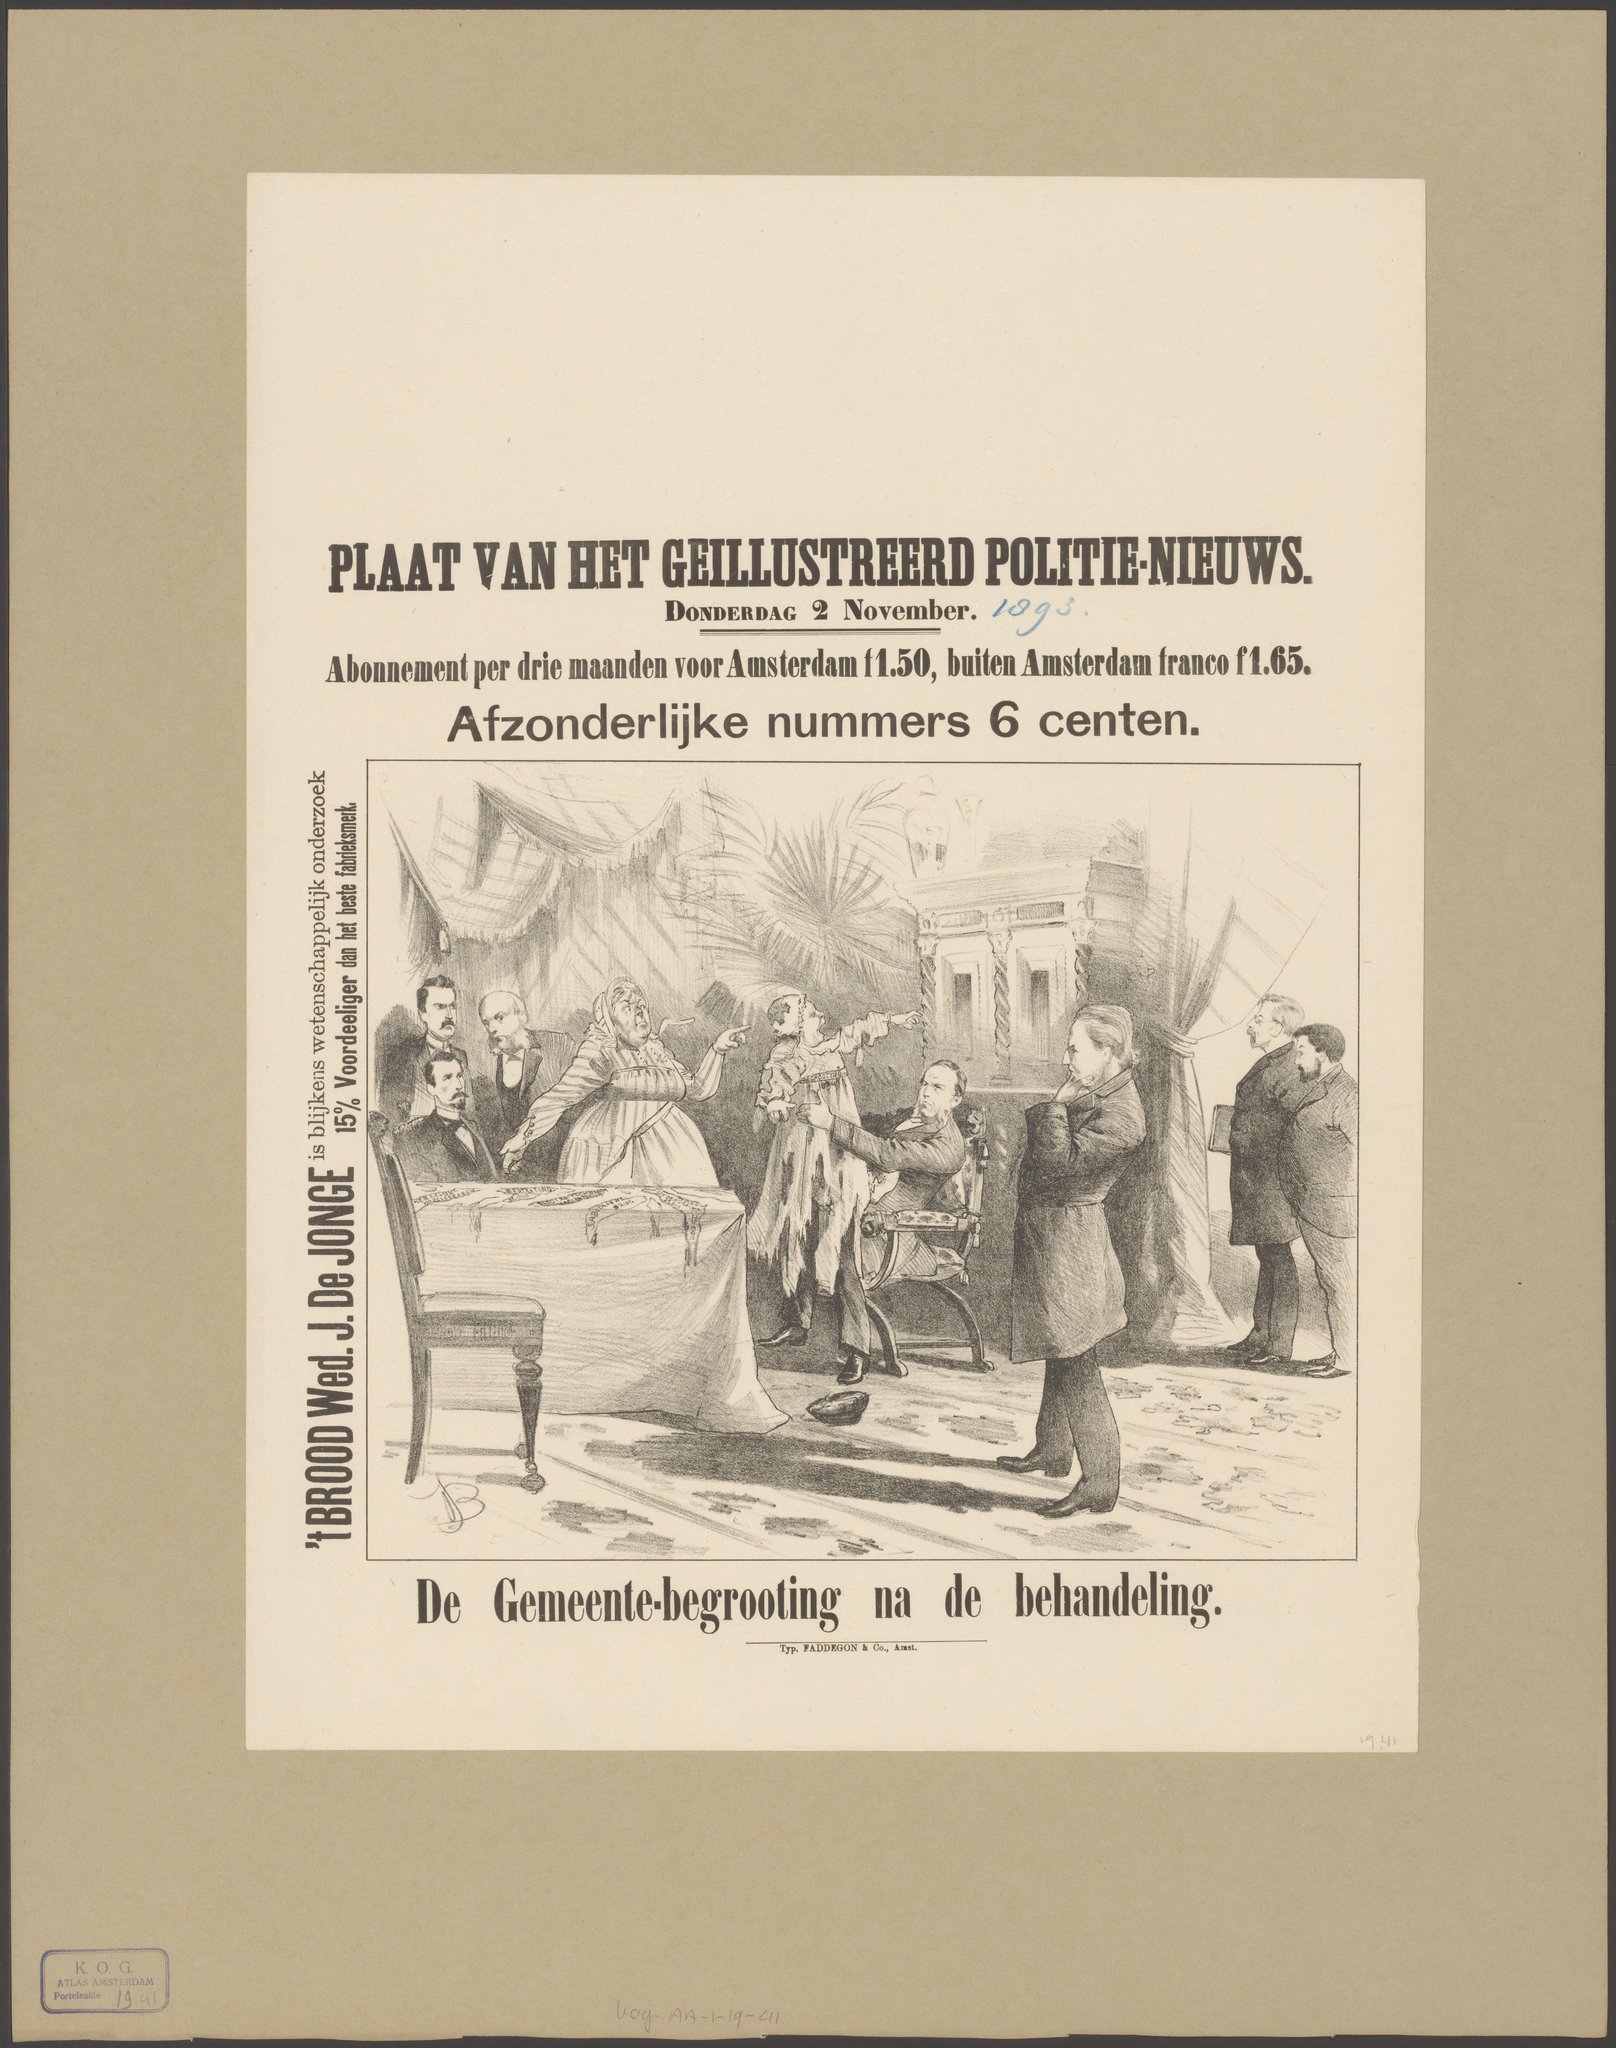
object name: cartoon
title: De Gemeente-begrooting na de behandeling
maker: johan braakensiek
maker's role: draughtsman, print maker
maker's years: 1858-1940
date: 1893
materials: paper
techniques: letterpress printing, lithograph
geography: amsterdam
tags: city council, clothed in rags, political caricatures and satires, amsterdam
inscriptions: collector's mark: ‘19,41’ Lugt 1641b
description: Onderwerpsrubriek binnen de Atlas Amsterdam: Herinneringen aan regeringsleden en hunne huisgezinnen [na 1800].